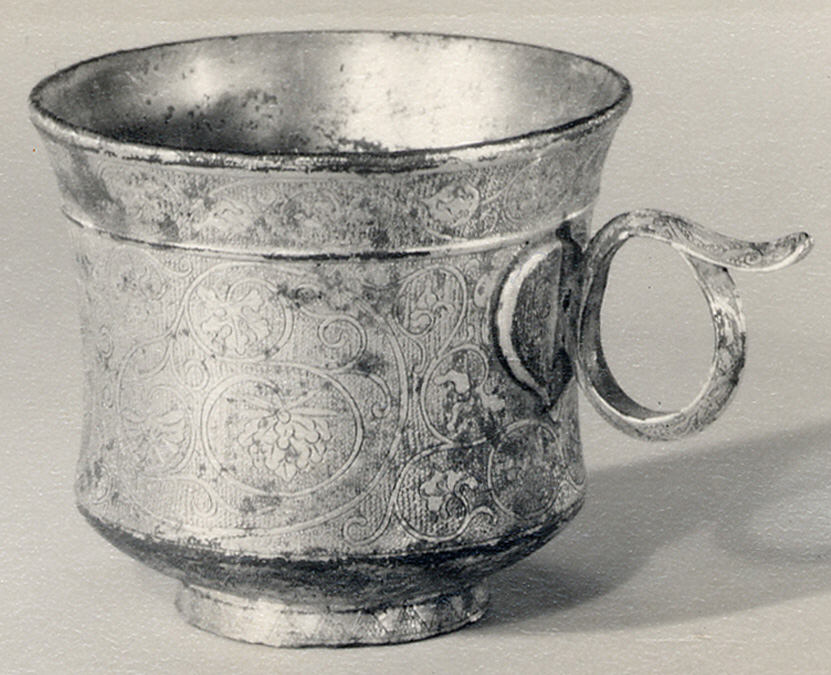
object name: cup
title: Cup with ring handle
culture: chinese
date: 701-800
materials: gilt bronze